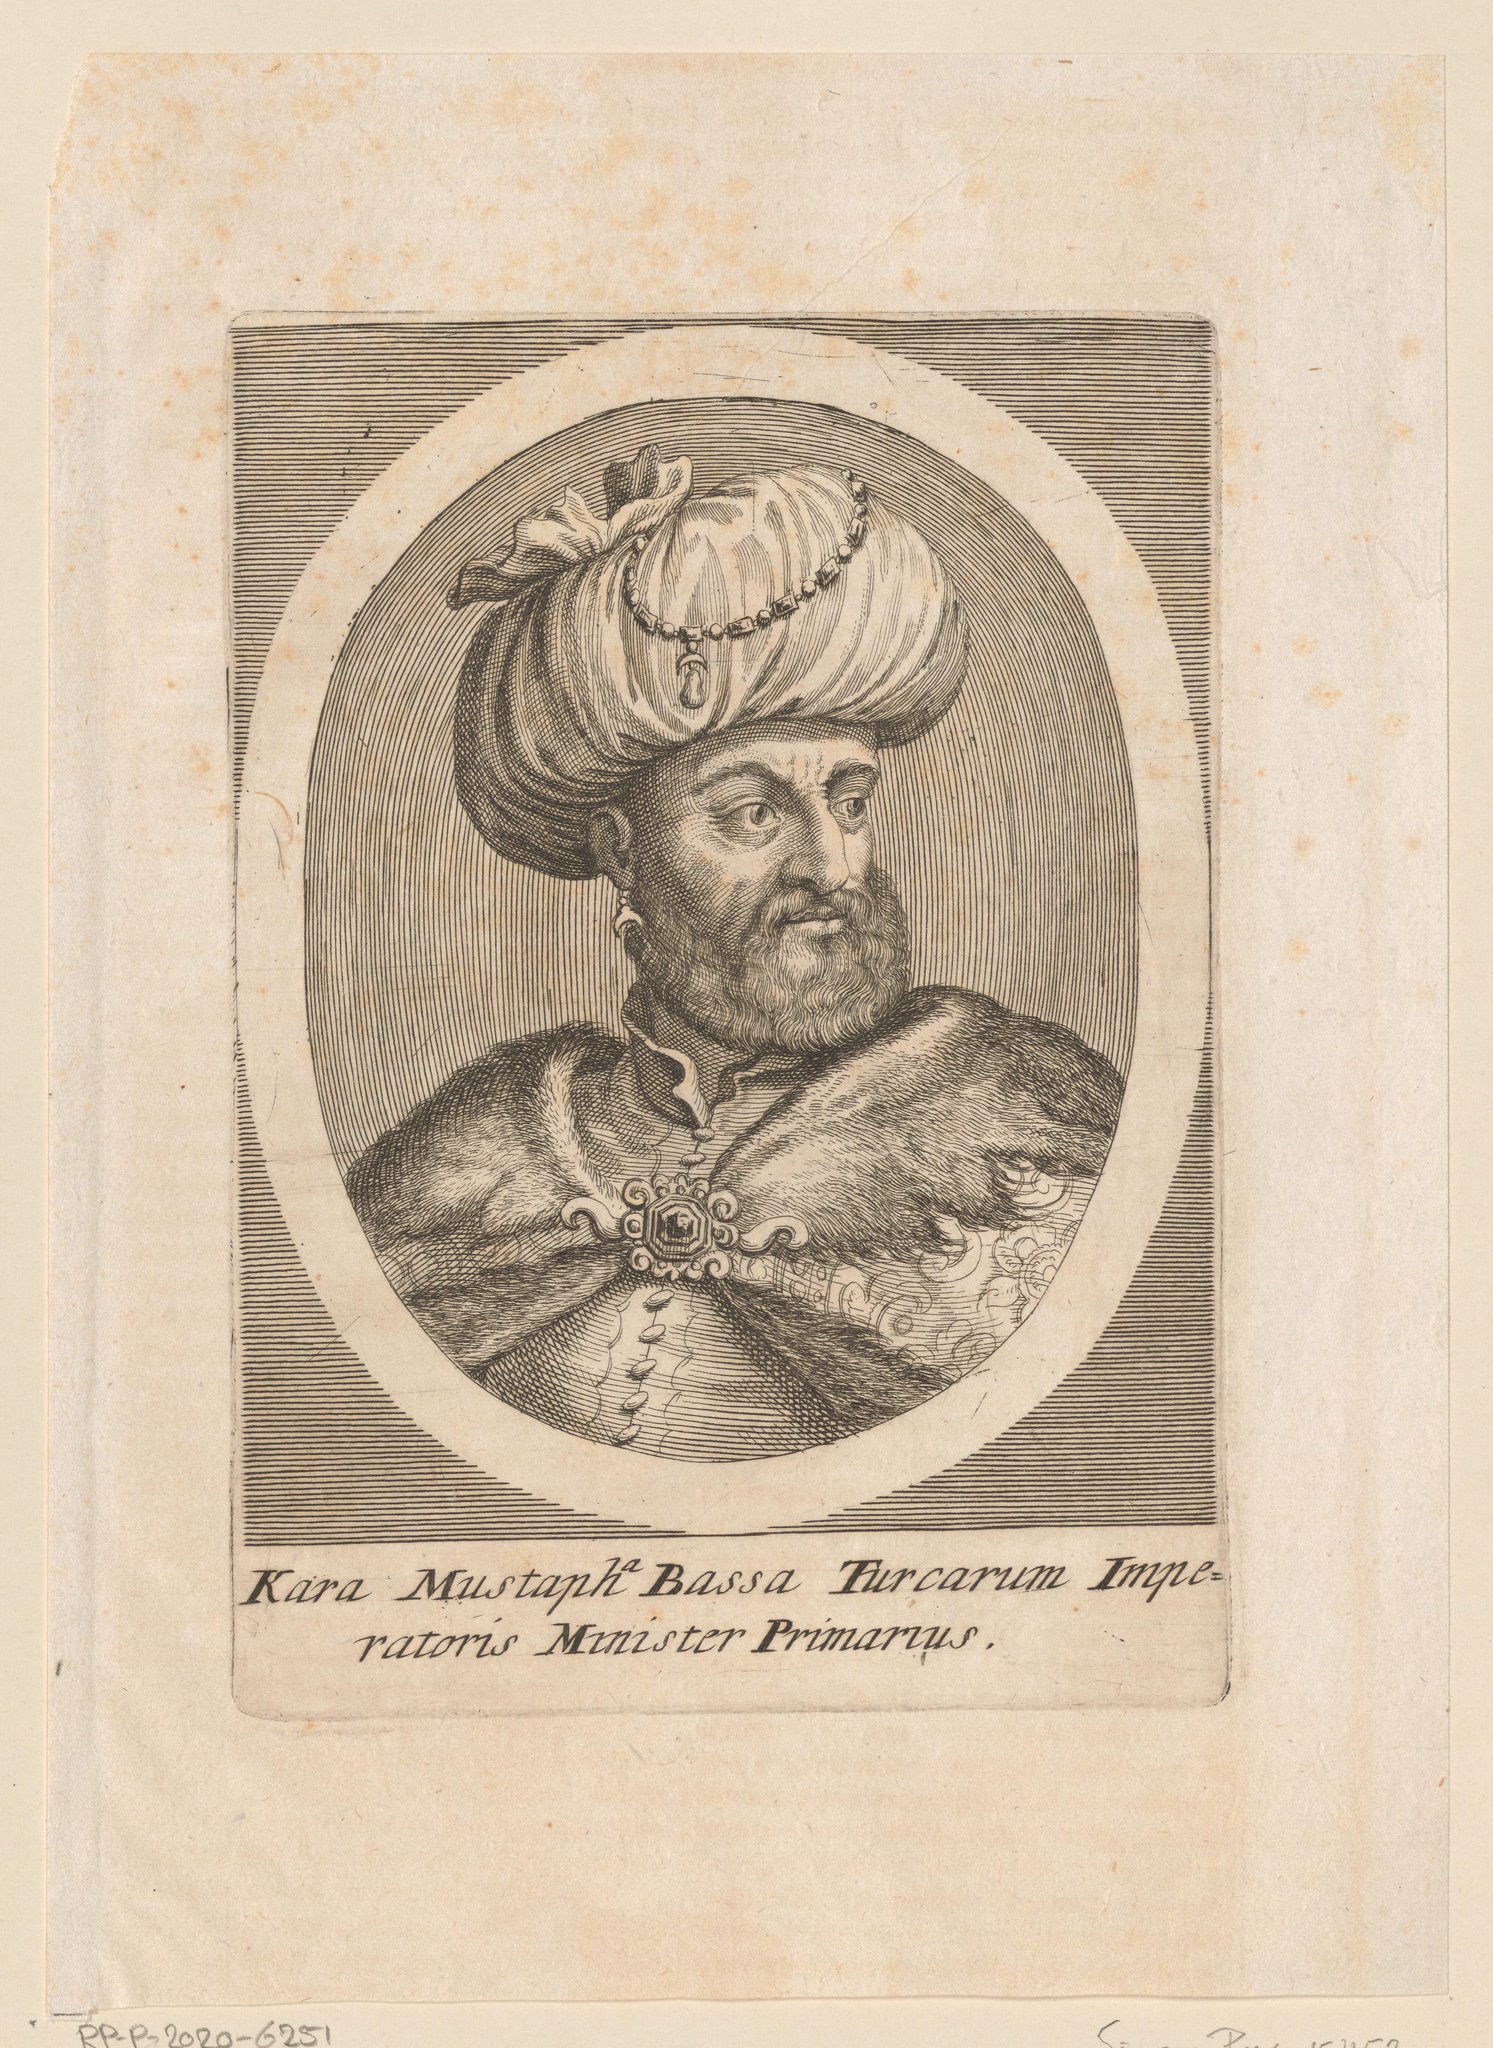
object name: print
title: Portret van Kara Mustafa Pasja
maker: Anonymous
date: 1659-1699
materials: paper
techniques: engraving, etching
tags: historical persons